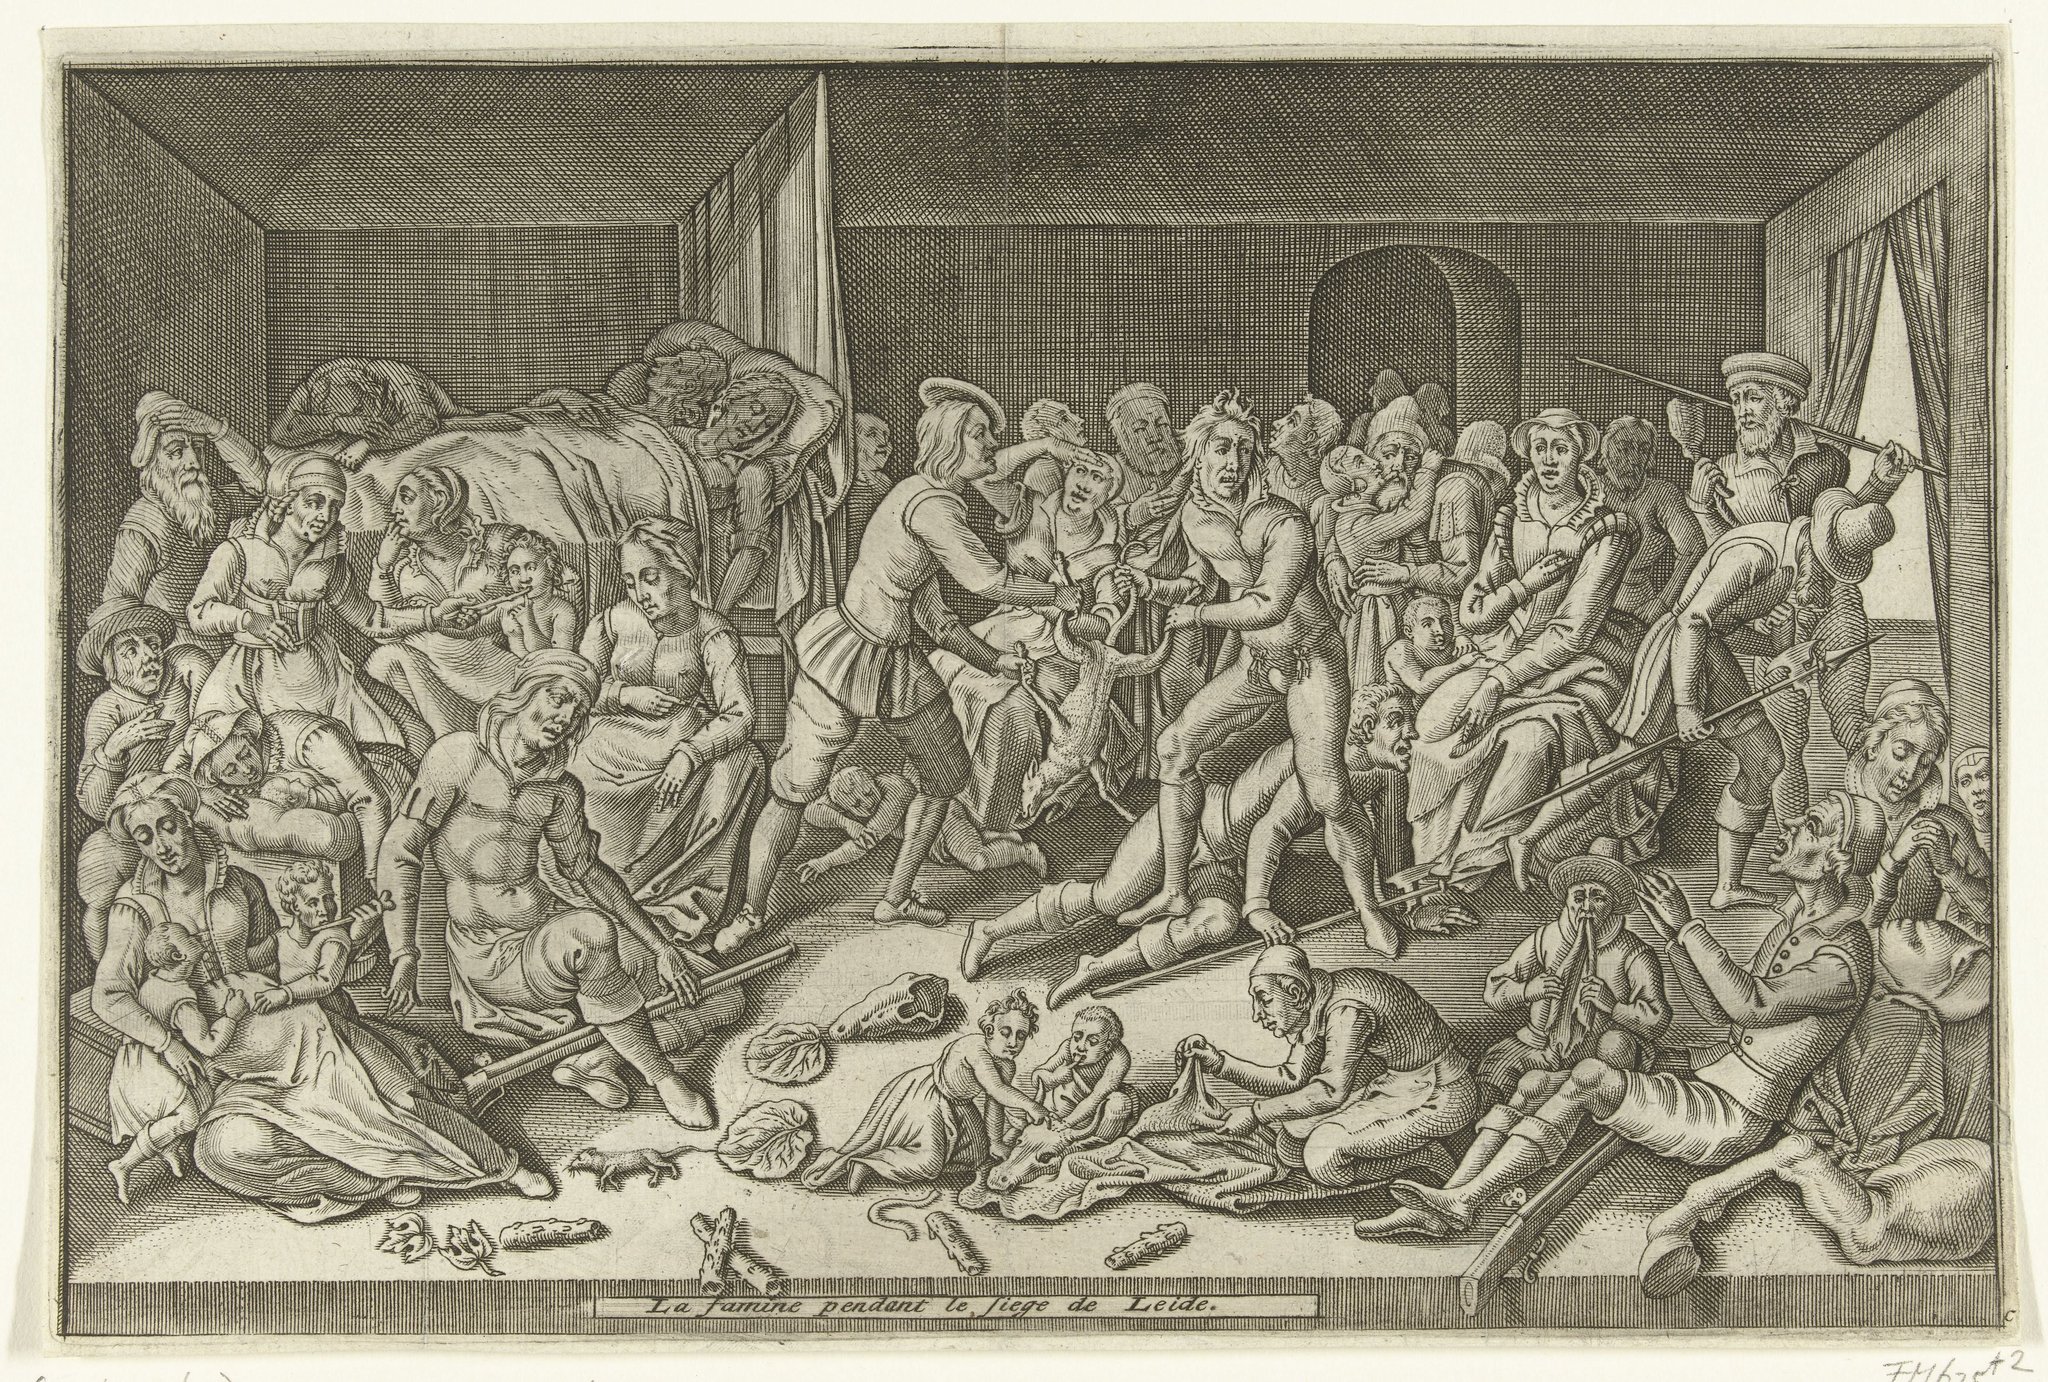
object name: history print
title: La famine pendant le siege de Leide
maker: willem de haen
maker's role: draughtsman, print maker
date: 1612-1614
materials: paper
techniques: engraving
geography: northern netherlands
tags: starvation, famine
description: Hongersnood onder de Leidenaren, tijdens het beleg van Leiden, 1574. Interieur met groep Leidse mannen en vrouwen die honger lijden, sterven van uitputting en honger en vechten om het schaarse voedsel.